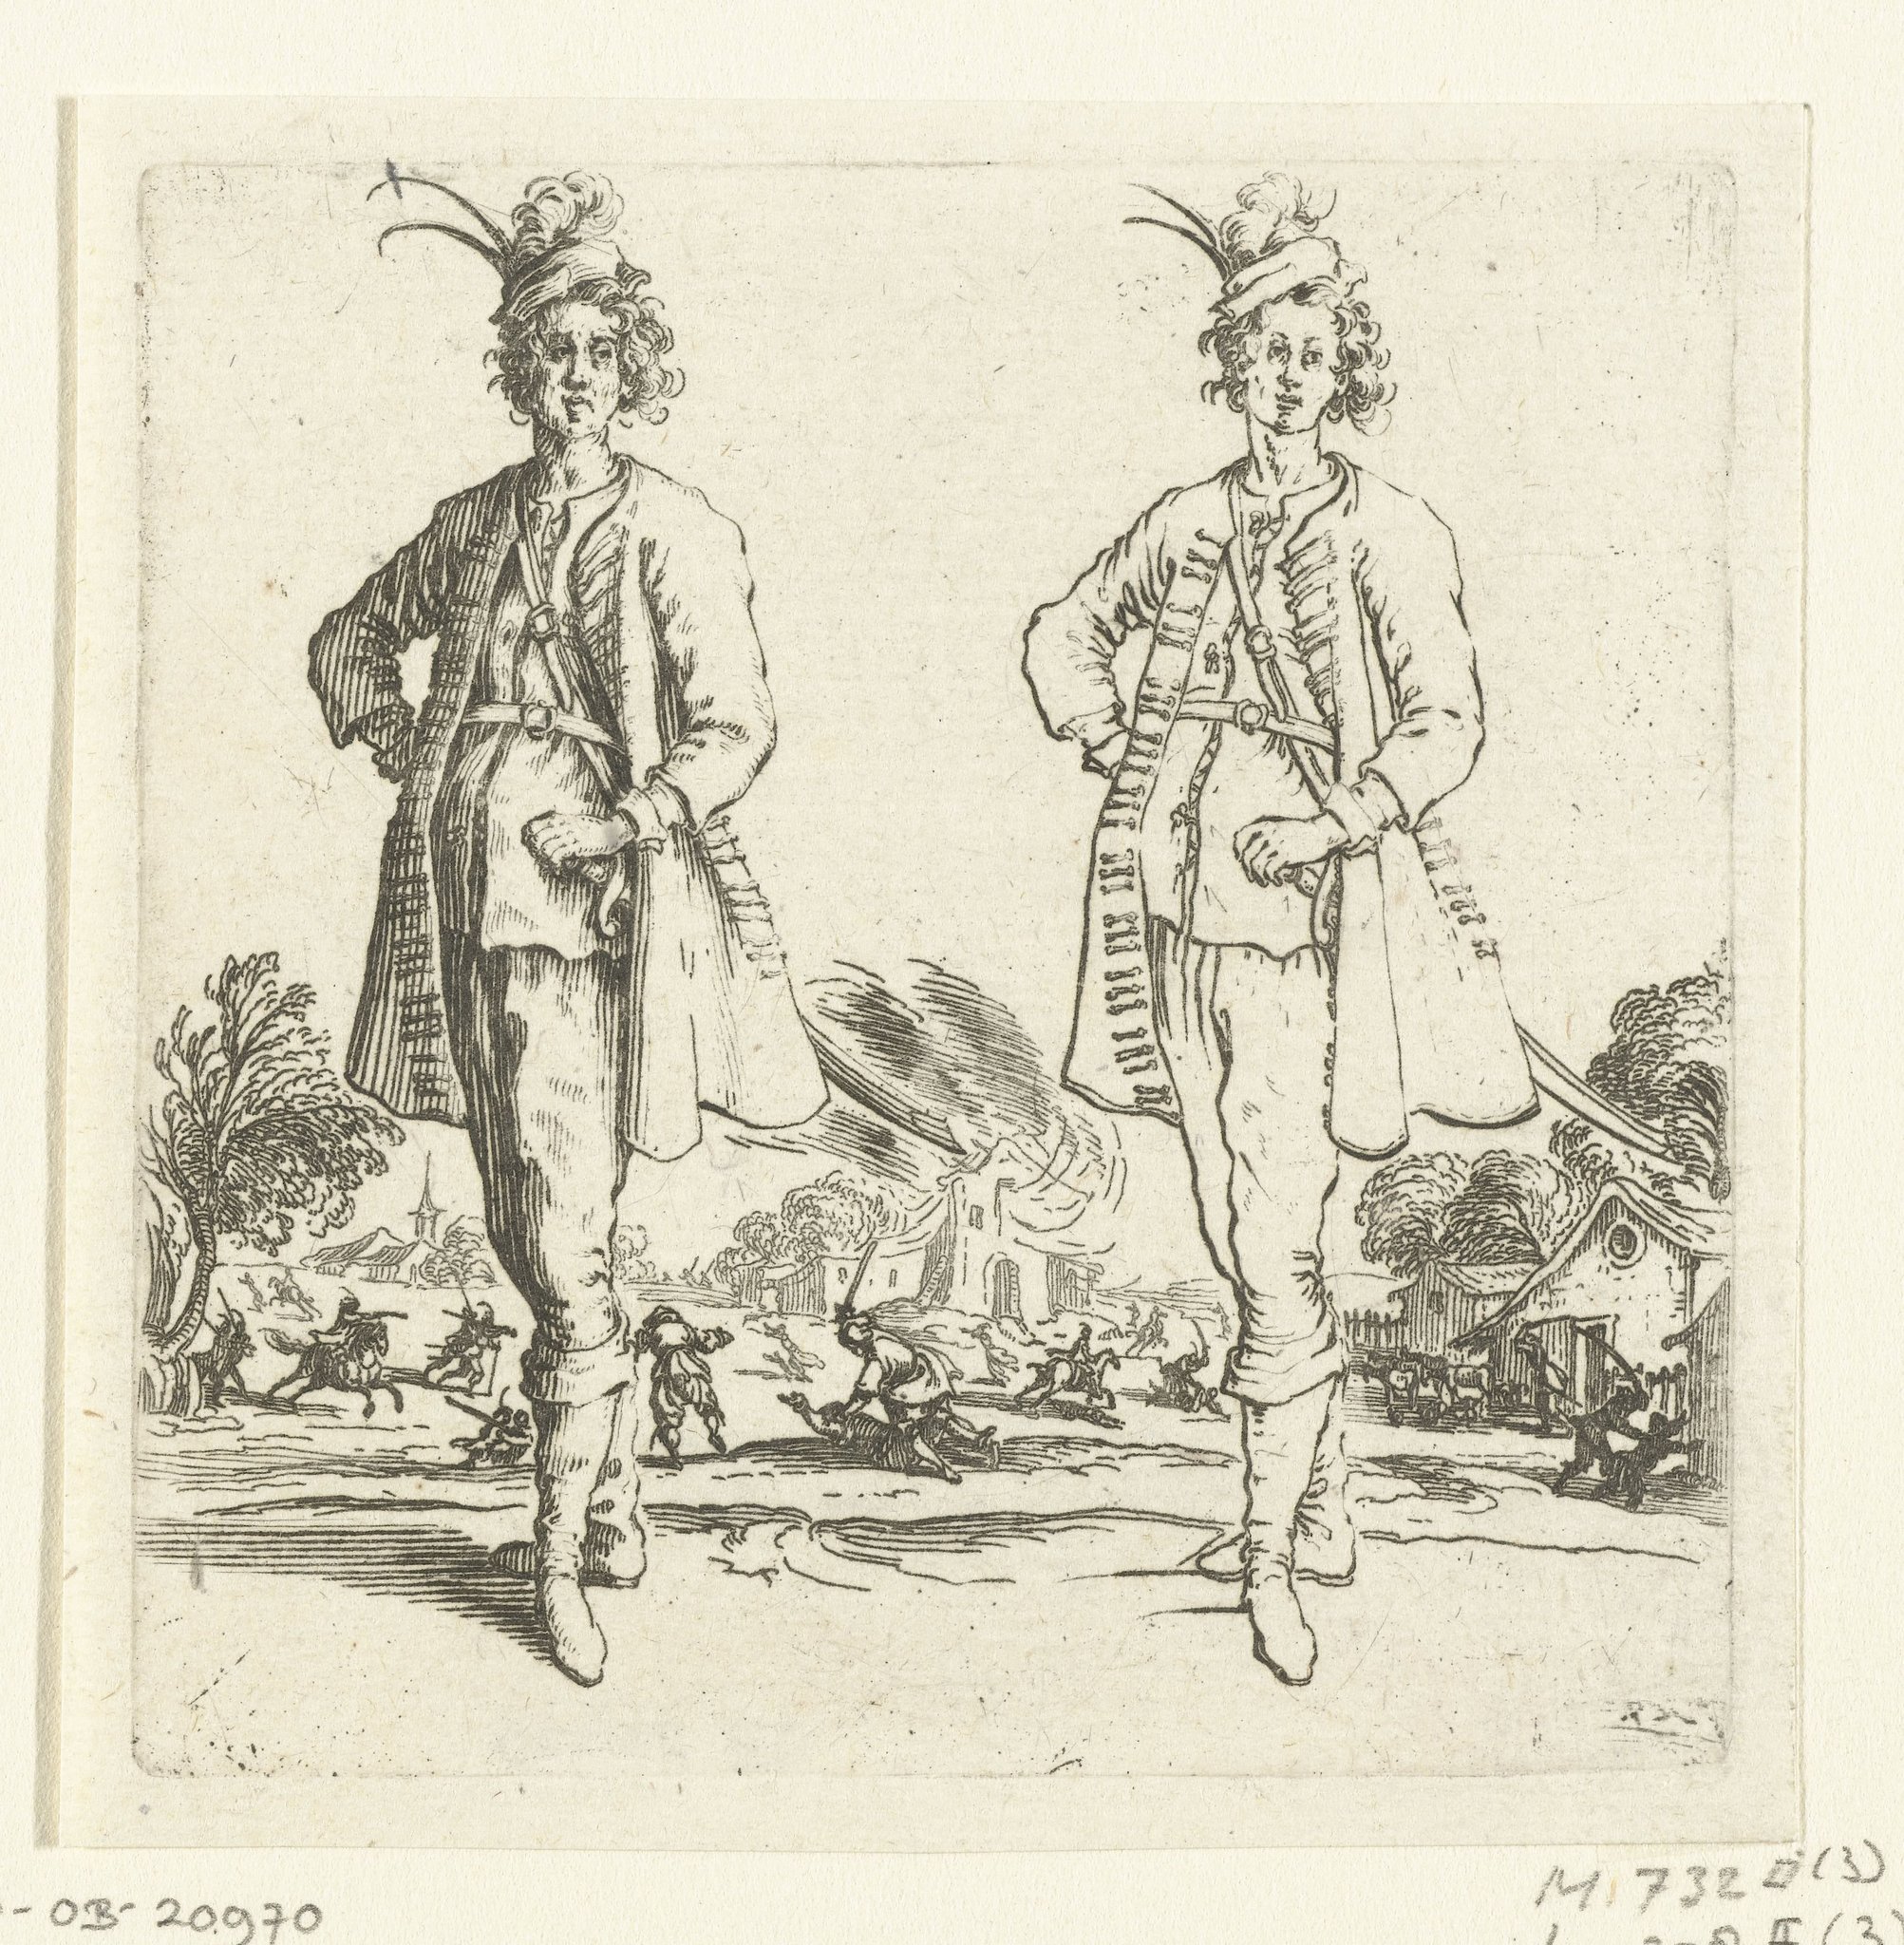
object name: print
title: Diverse figuren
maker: jacques callot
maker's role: draughtsman, print maker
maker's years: 1592-1635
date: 1621-1624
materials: paper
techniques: etching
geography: nancy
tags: private soldier, head-gear: hat (+ men's clothes)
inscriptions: collector's mark: Lugt 240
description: Een soldaat met een gepluimd hoedje op het hoofd, de rechterhand in de zij, de linkerhand op het gevest van zijn zwaard, van voren gezien, tweemaal afgebeeld: rechts als lijnfiguur, links meer uitgewerkt met schaduwpartijen. Op de achtergrond de plundering van een dorp door soldaten. Deze prent is onderdeel van een serie van 16 prenten (15 volgens Lieure; 17 resp. 16 incl. titelprent) met mannen en vrouwen in diverse houdingen. Mogelijk zijn deze prenten bedoeld geweest als tekenvoorbeelden.